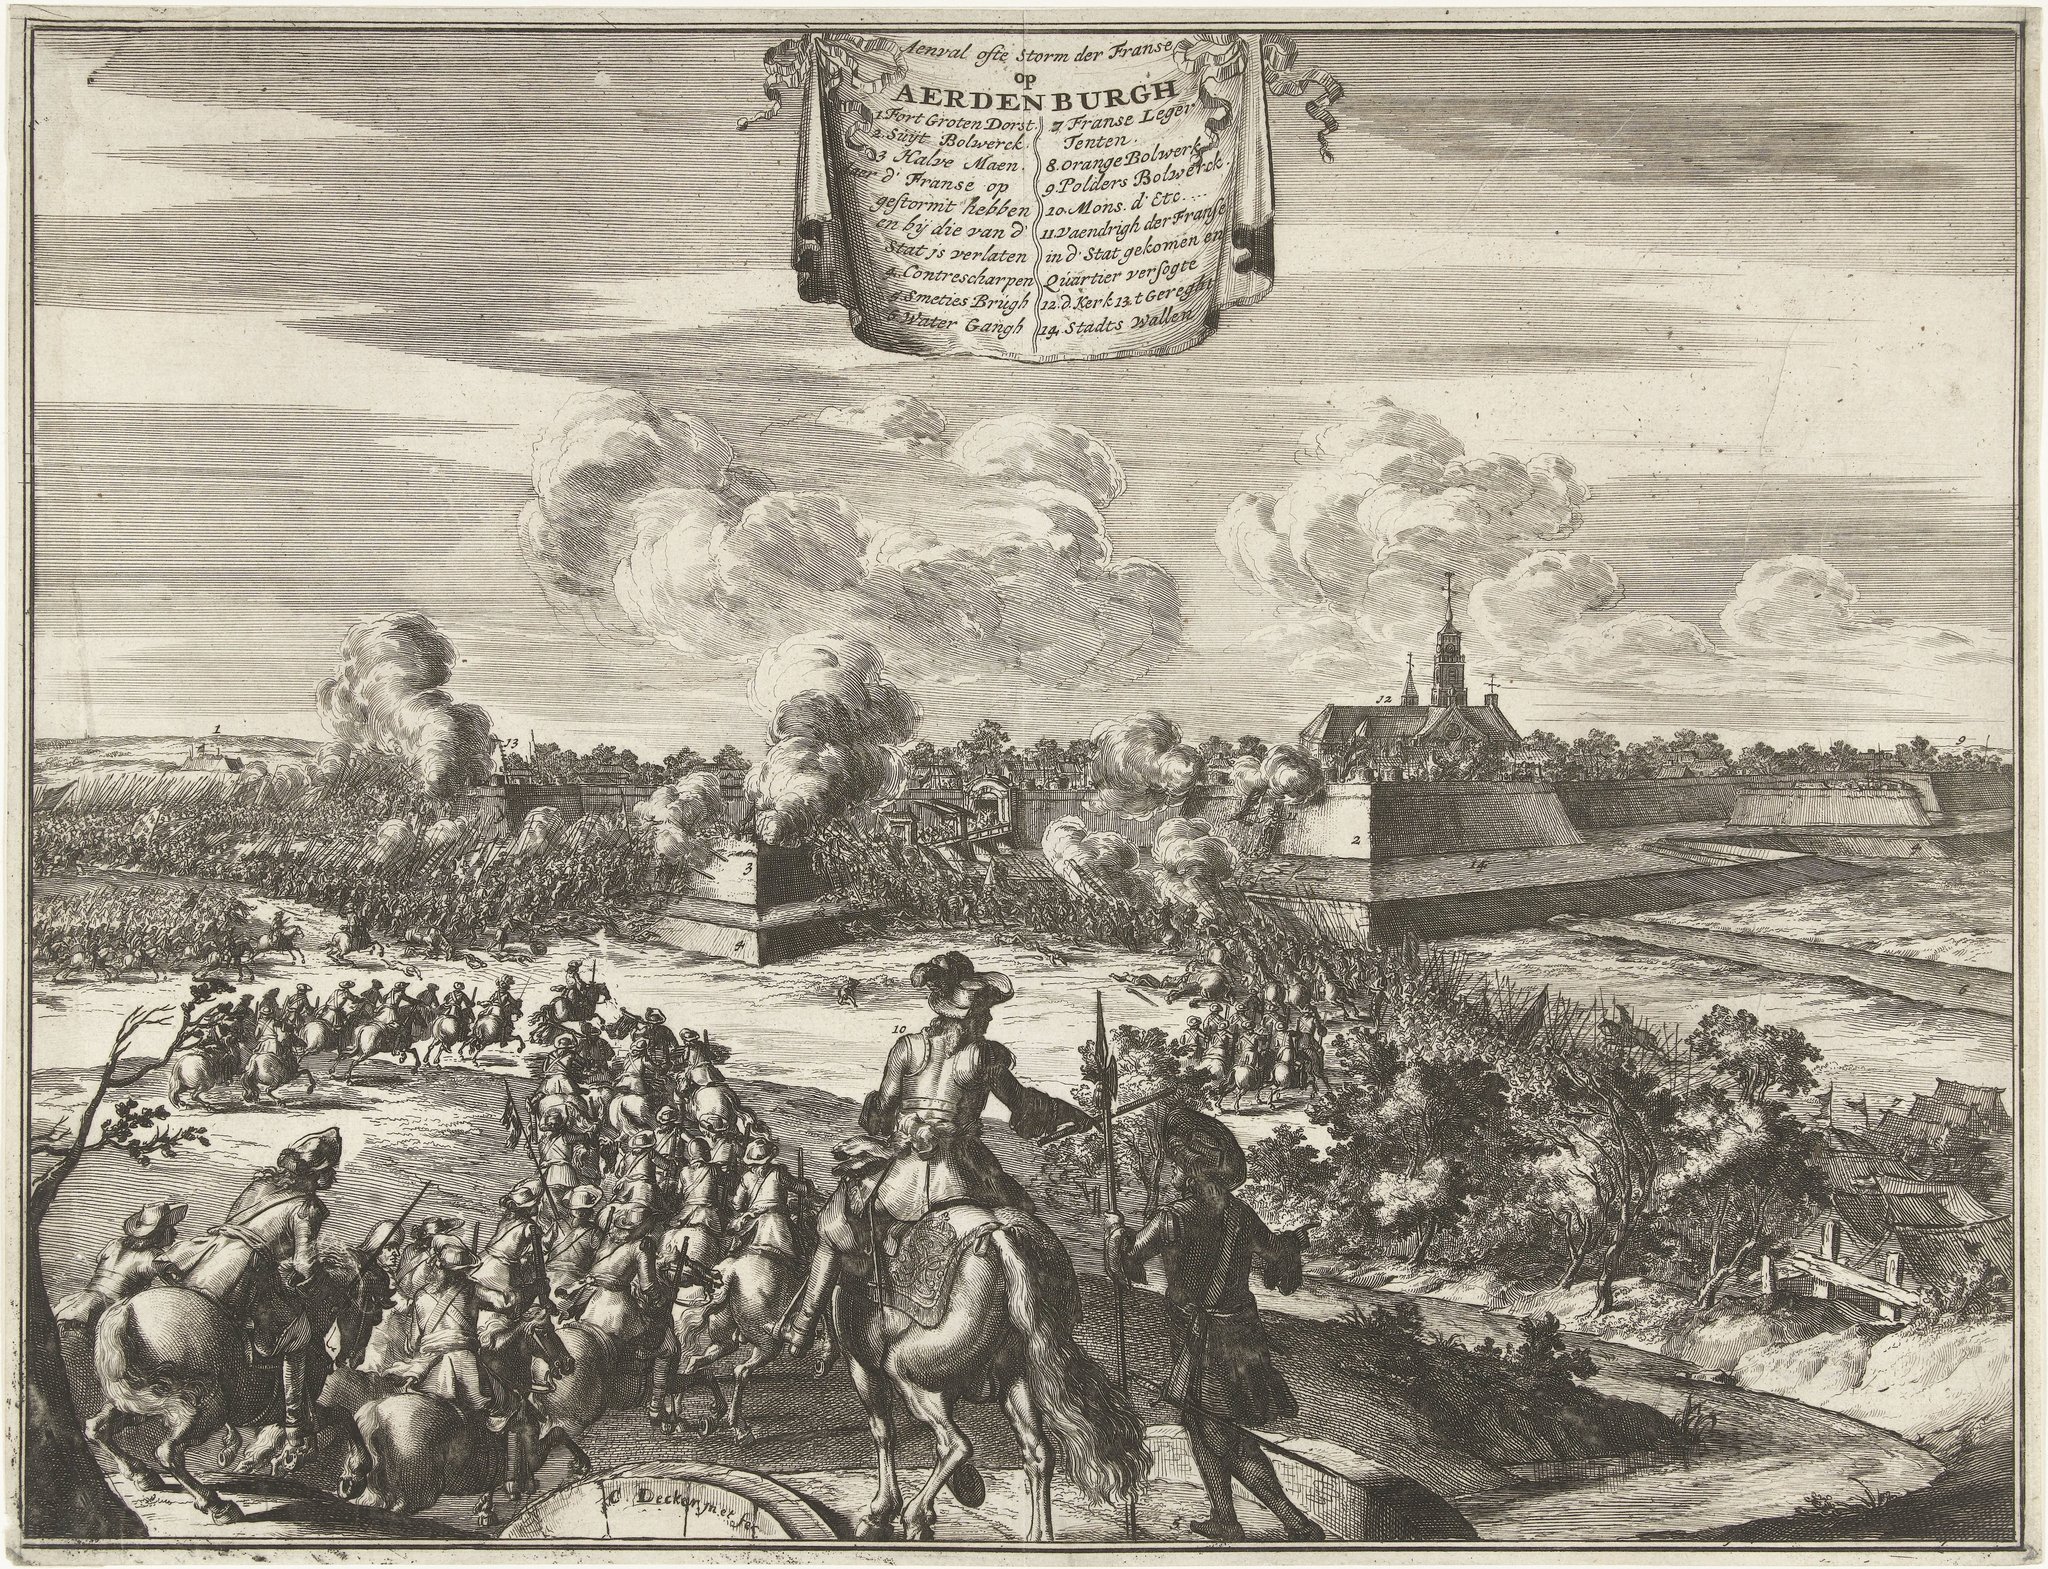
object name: print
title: Aenval ofte Storm der Franse op Aerdenburgh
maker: coenraet decker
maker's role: print maker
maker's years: 1650-1685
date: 1672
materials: paper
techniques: etching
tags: attack ~ siege, rampjaar (disaster year)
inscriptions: collector's mark: Lugt 2228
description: De bestorming van de versterkte stad Aardenburg door het Franse leger op 29 juni 1672. Bovenaan een doek met de titel en de legenda voor de cijfers 1-14 voor verschillende delen van de stad en vesting.